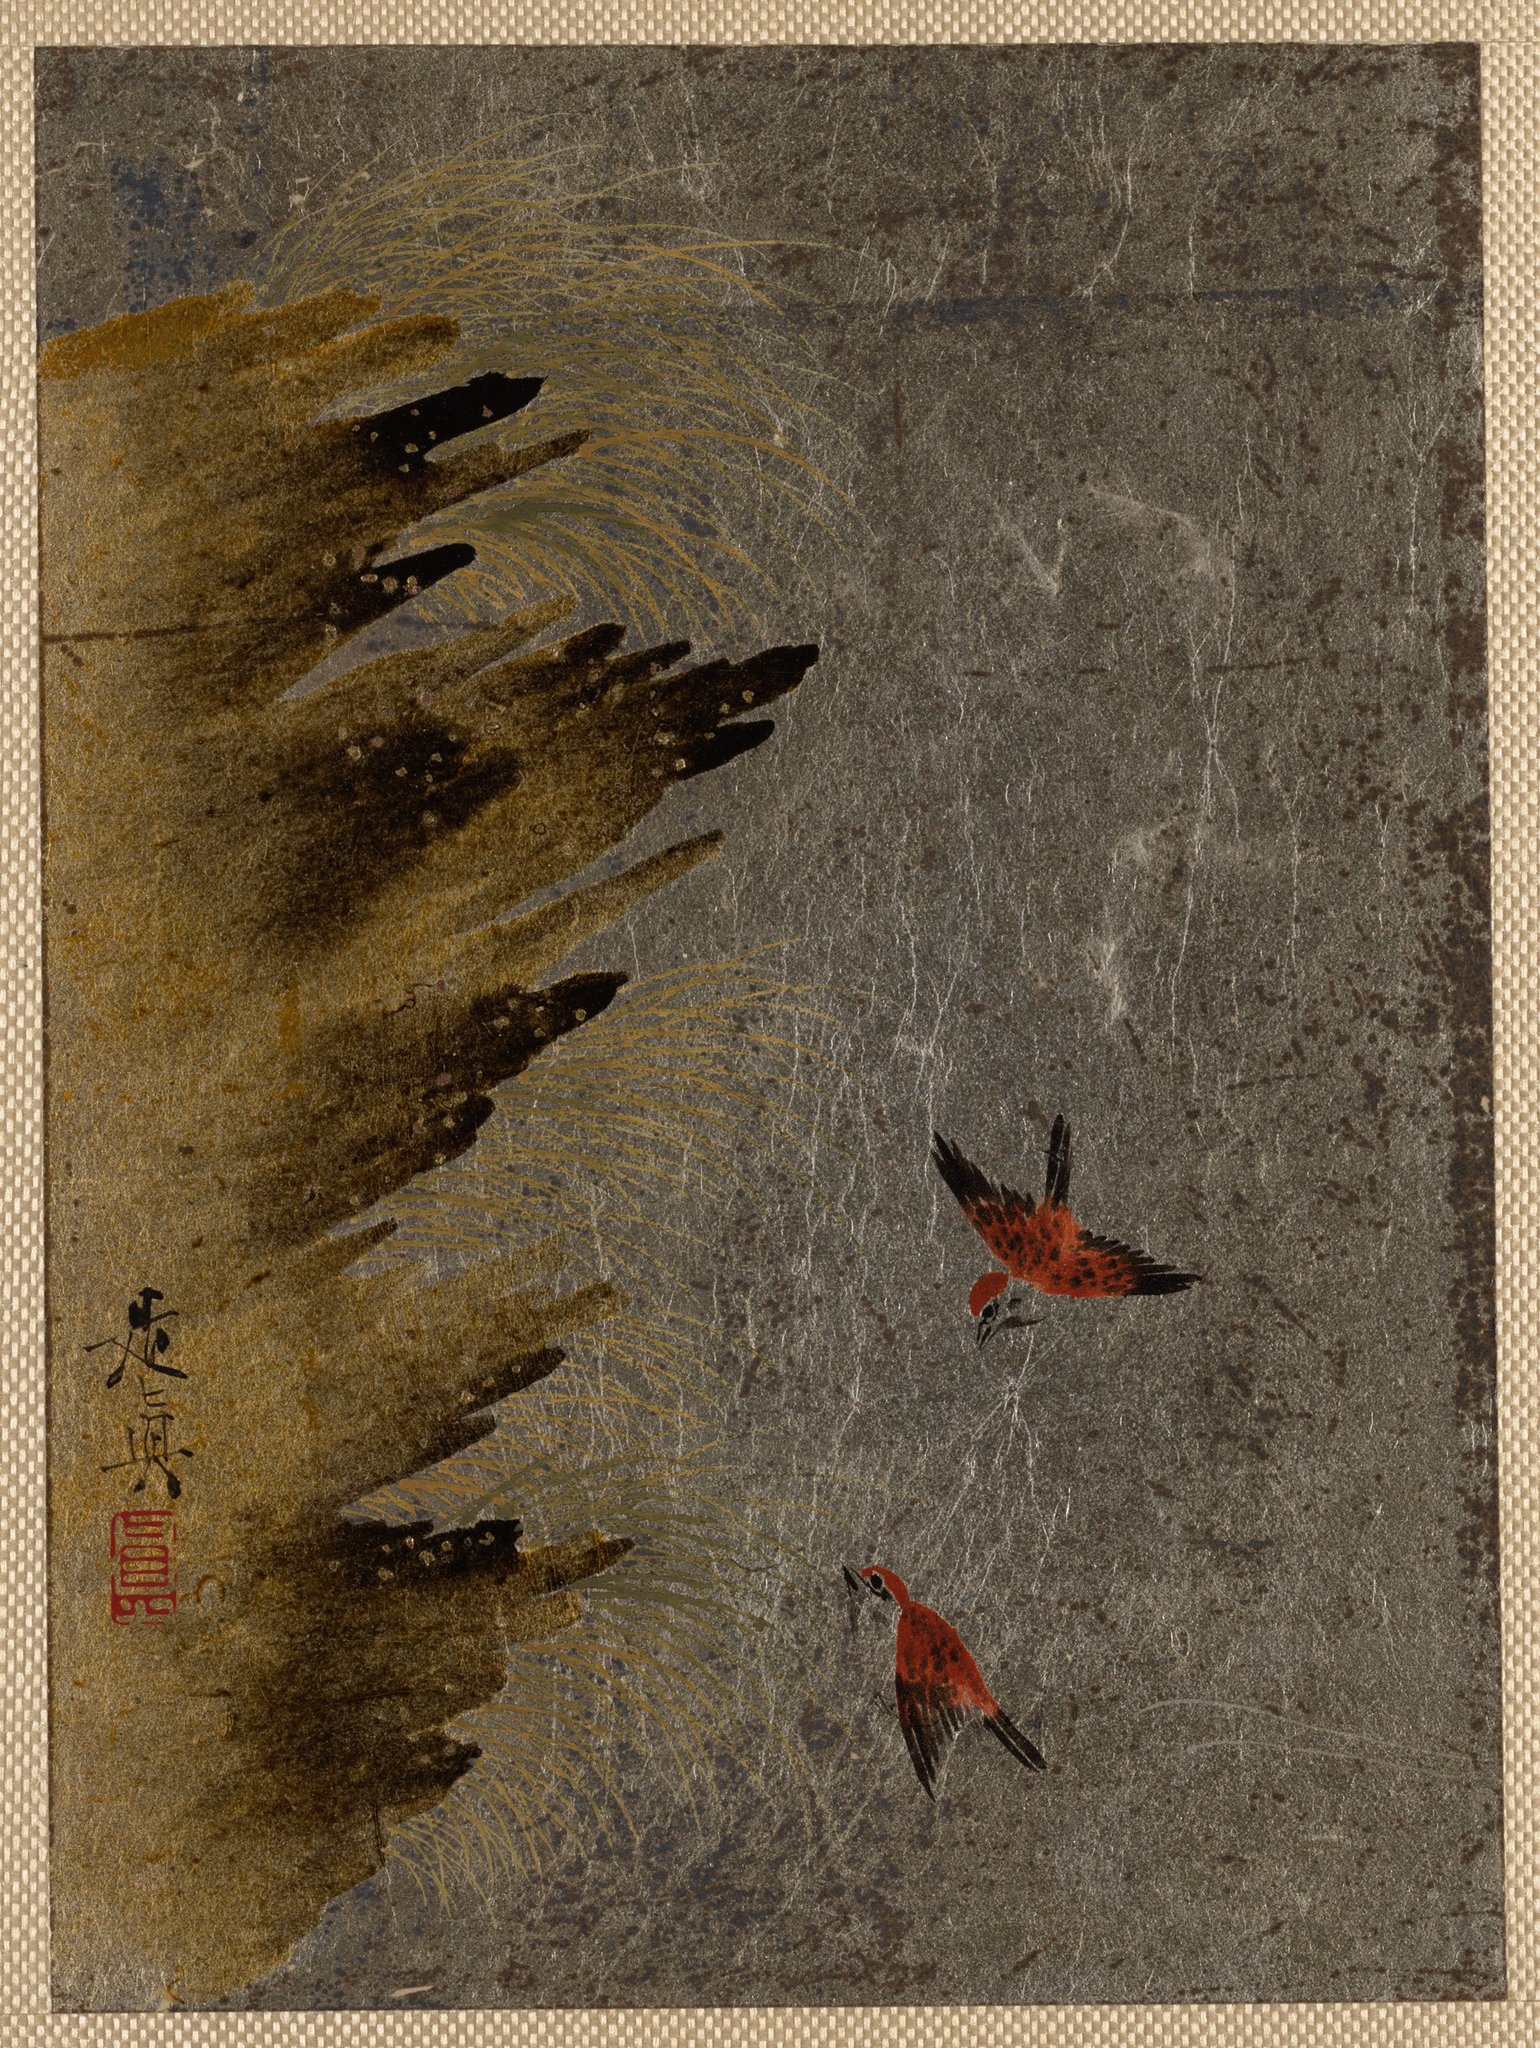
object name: album leaf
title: Birds and Jutting Rocks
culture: japanese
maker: shibata zeshin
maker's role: artist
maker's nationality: japanese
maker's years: 1807-1891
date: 1807-1868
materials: gold, lacquer, paper, silver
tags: birds